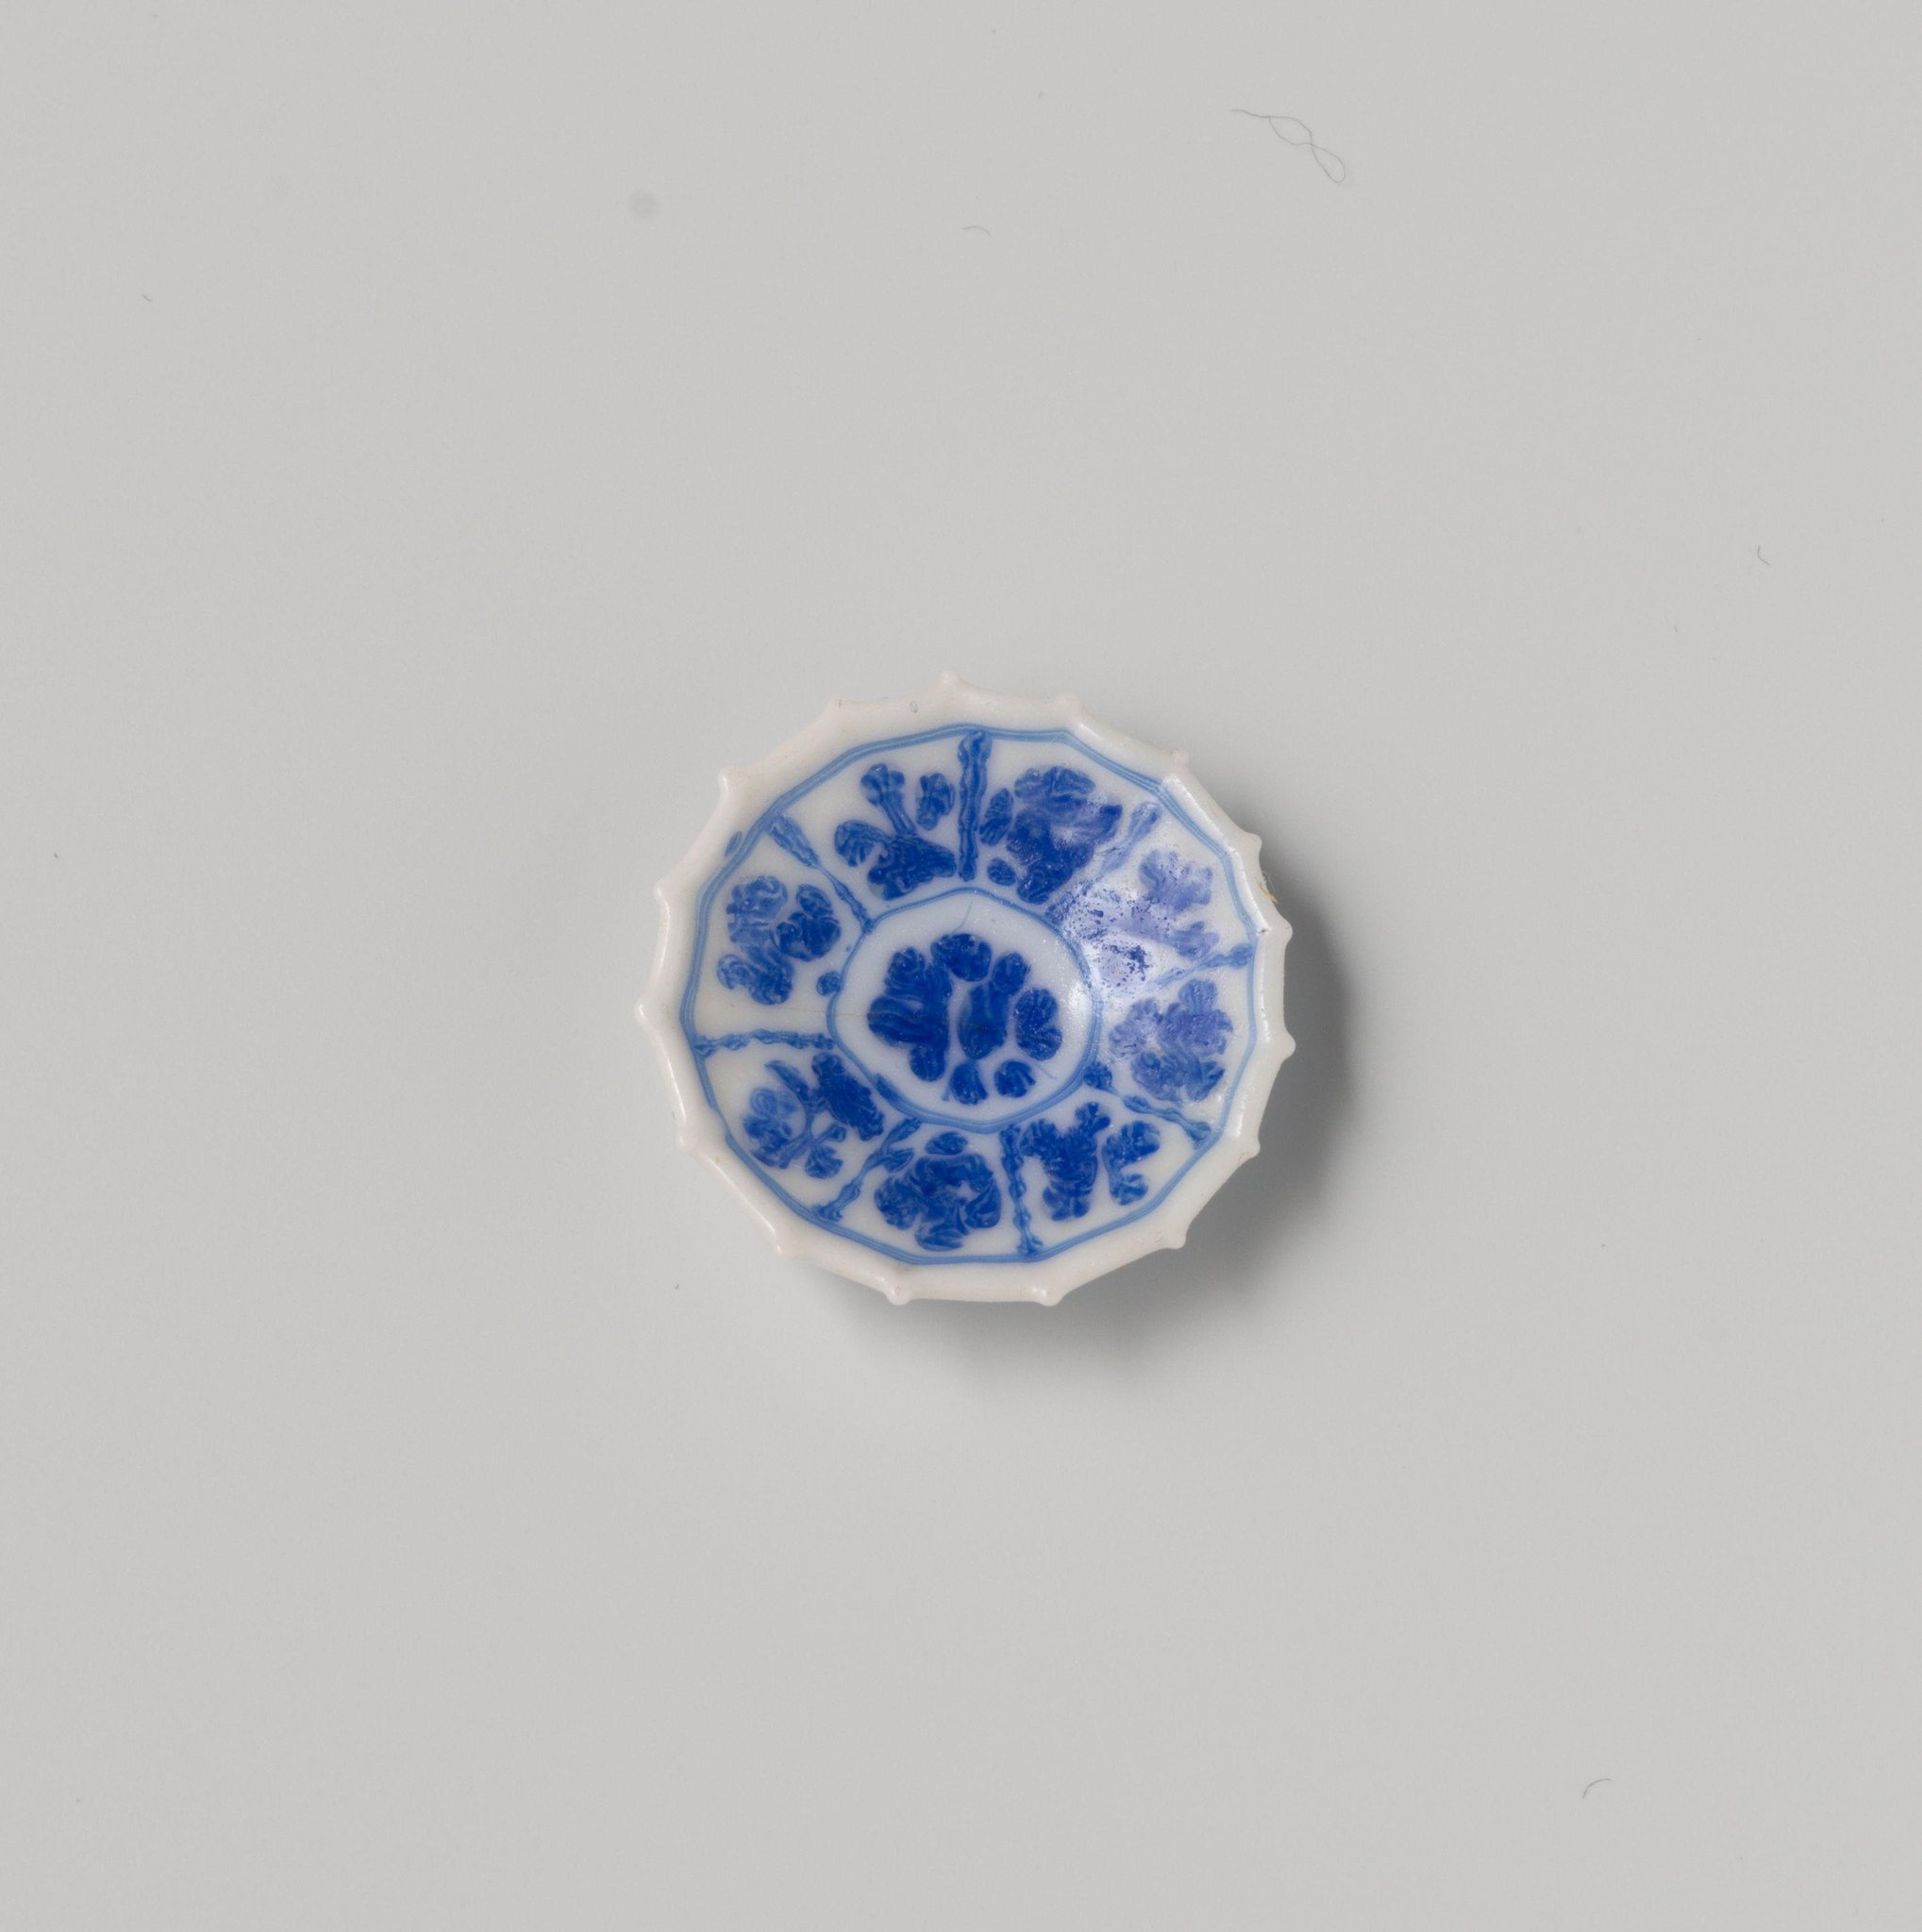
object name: miniature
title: Schotel van melkglas met blauwe emailverf beschildering, imitatie Chinees porselein; bloemmotieven in vakken in Kraakporselein stijl; dubbelwandig, de rand in punten geknepen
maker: Anonymous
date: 1675-1710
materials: glass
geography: amsterdam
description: Schotel van melkglas met blauwe emailverf beschildering, imitatie Chinees blauw porselein met decoratie van bloemmotieven in vakken in kraakporselein stijl; dubbelwandige schotel, de rand in punten geknepen.